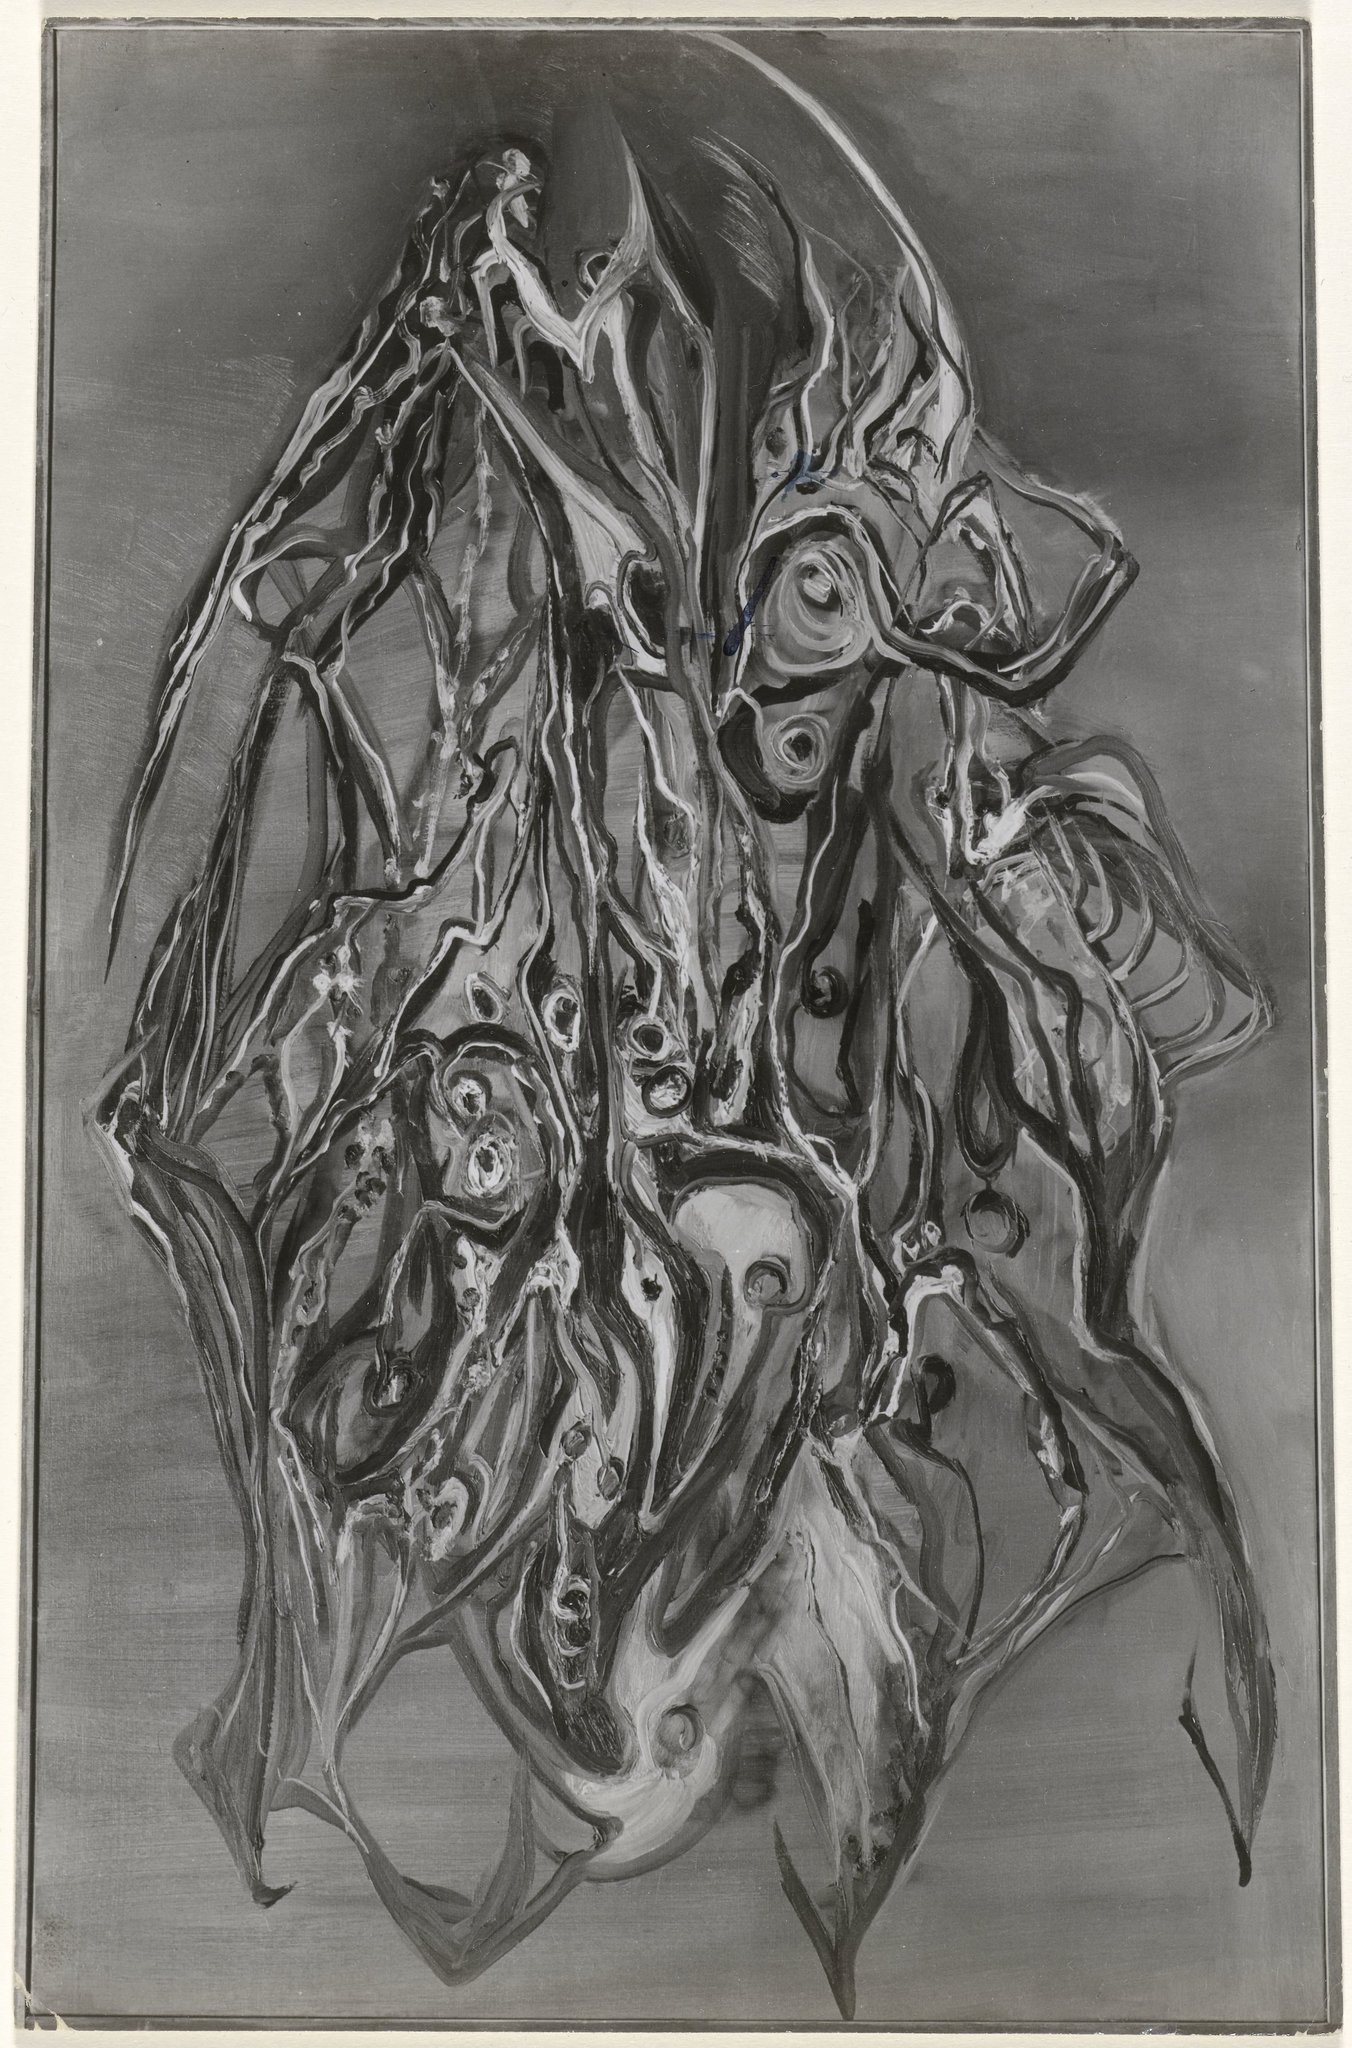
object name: photograph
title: Wolfgang Paalen 98. Le Pterodactyle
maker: lilly samuel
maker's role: fotograaf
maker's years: 1909-1944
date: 1938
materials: photographic support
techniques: gelatin silver print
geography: amsterdam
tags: amsterdam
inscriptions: stamp: ‘galerie Robert Keizersgracht 527 Amsterdam’, stamp: ‘Lilly Samuel foto mono’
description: Onderdeel van een serie betreffende een reizende tentoonstelling "Exposition Internationale du Surréalisme", in galerie Robert te Amsterdam